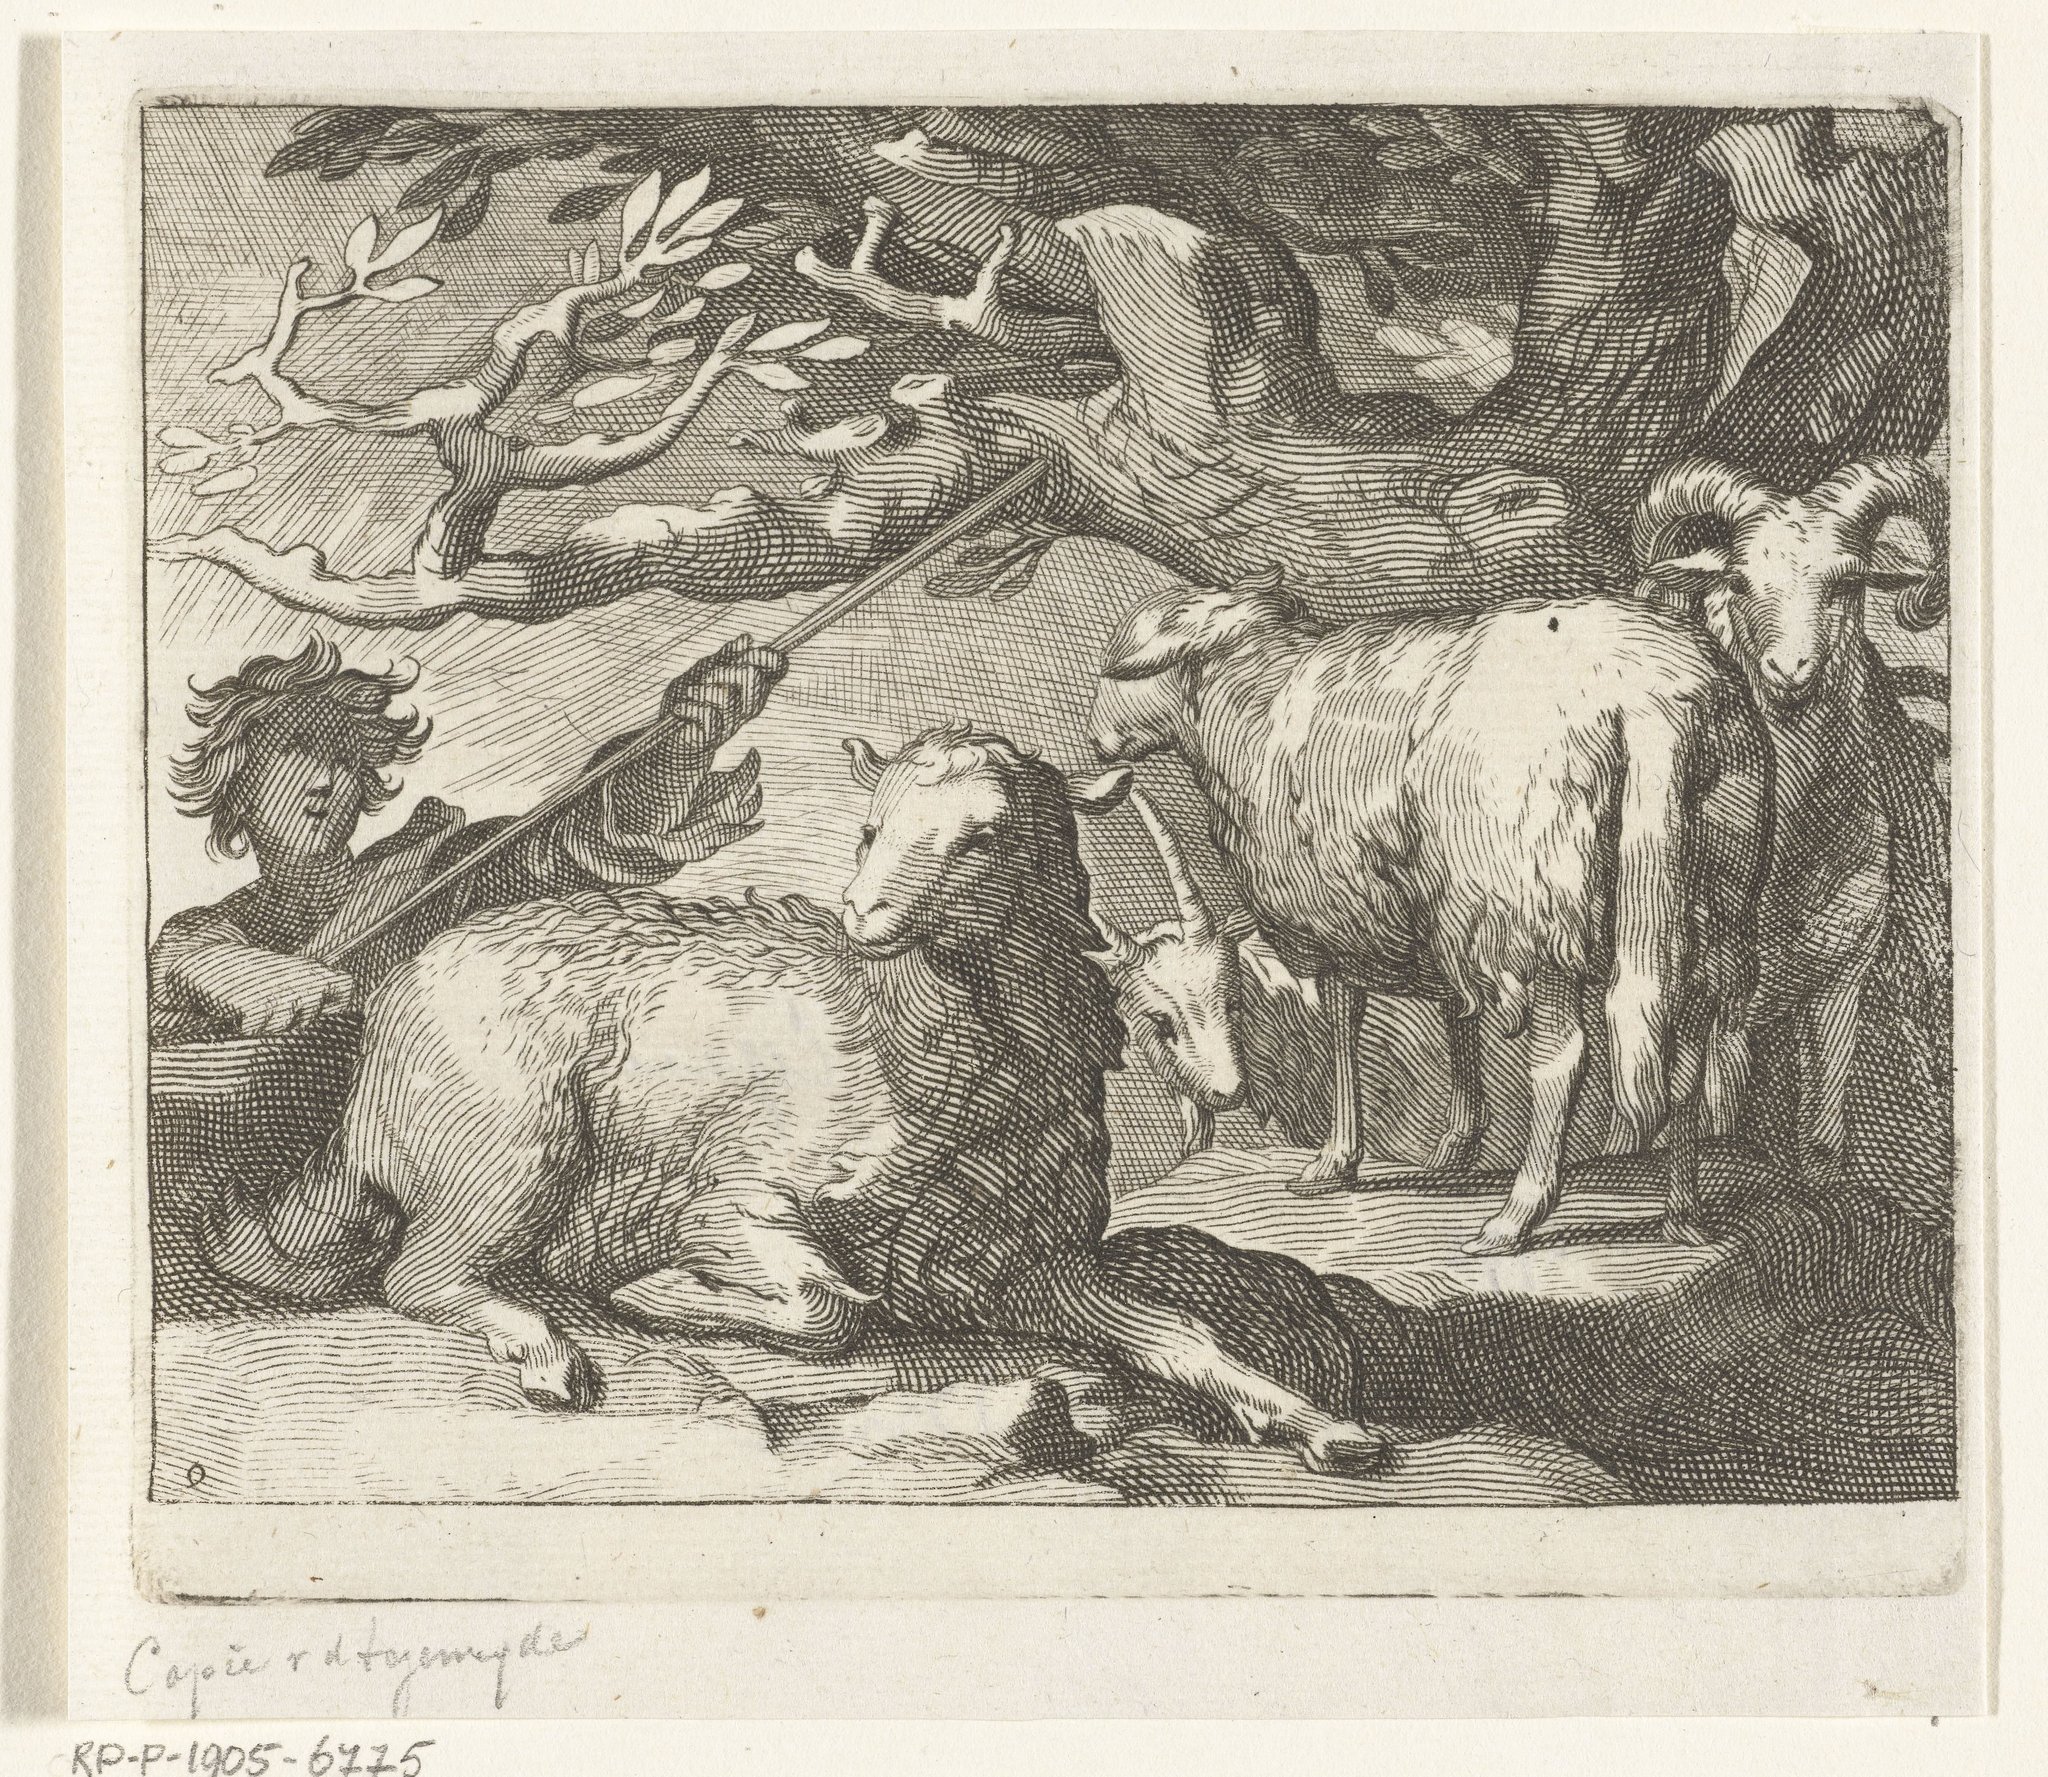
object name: print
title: Herder met schapen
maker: Anonymous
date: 1611-1661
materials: paper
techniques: engraving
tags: herding, herdsman, herdswoman, shepherd, shepherdess, cowherd, etc., sheep, dog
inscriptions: collector's mark: Lugt 2228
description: Kopie in spiegelbeeld naar prent uit serie met veertien prenten zogenaamde Pastoralen van B.A. Bolswert naar ontwerp van Abraham Bloemaert.